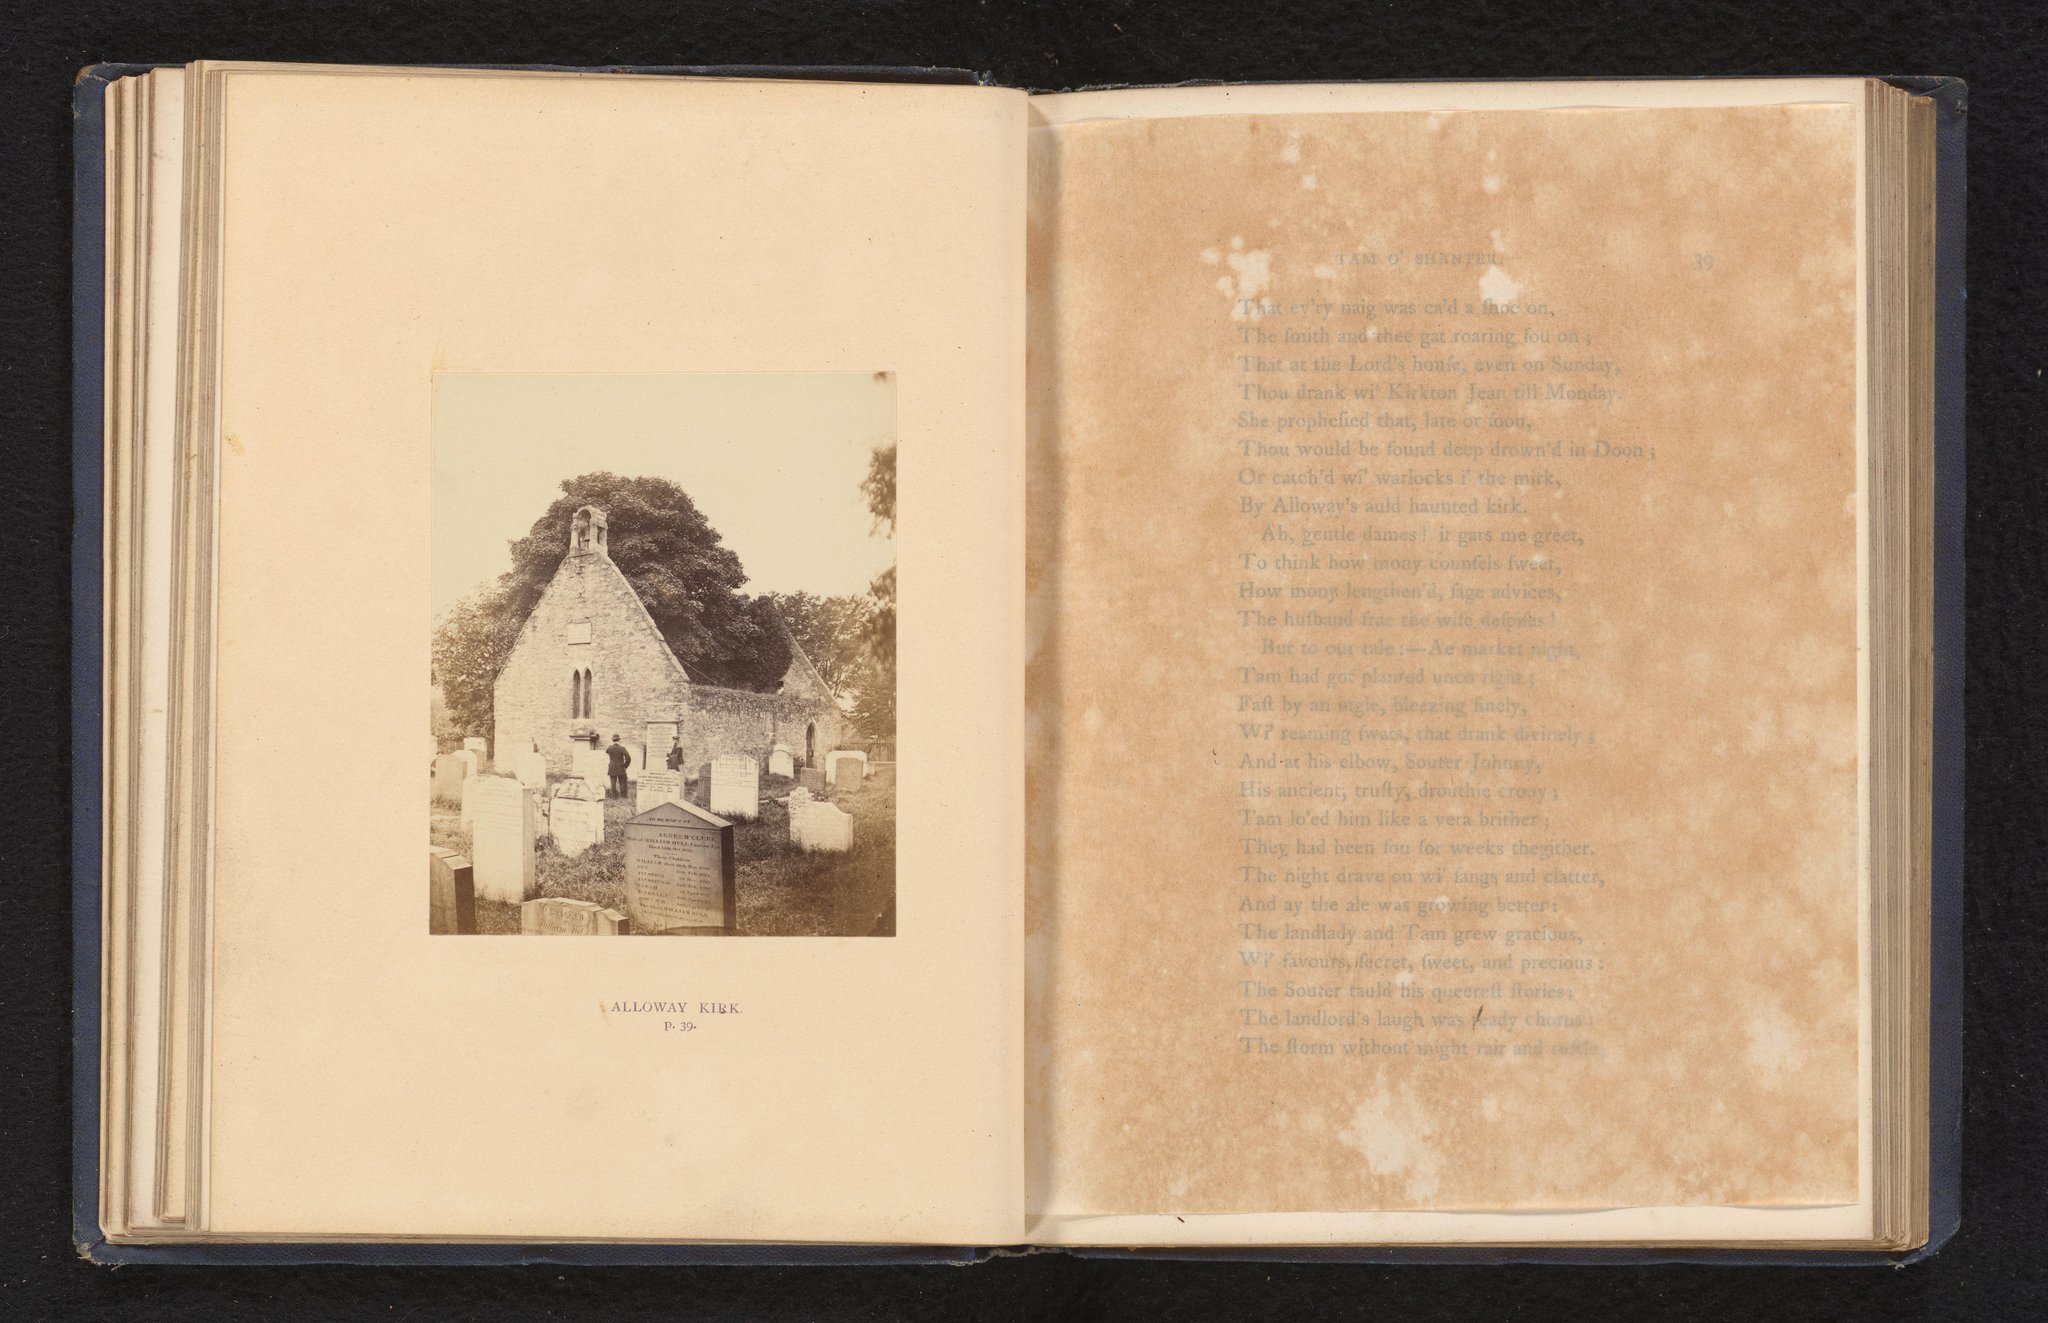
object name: page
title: Ruïne van Alloway Auld Kirk te Alloway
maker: stephen thompson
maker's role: fotograaf, schrijver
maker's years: 1831-1893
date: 1863-1868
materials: paper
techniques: albumen print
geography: alloway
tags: landscape with ruins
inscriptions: inscription: ‘P. 39.’